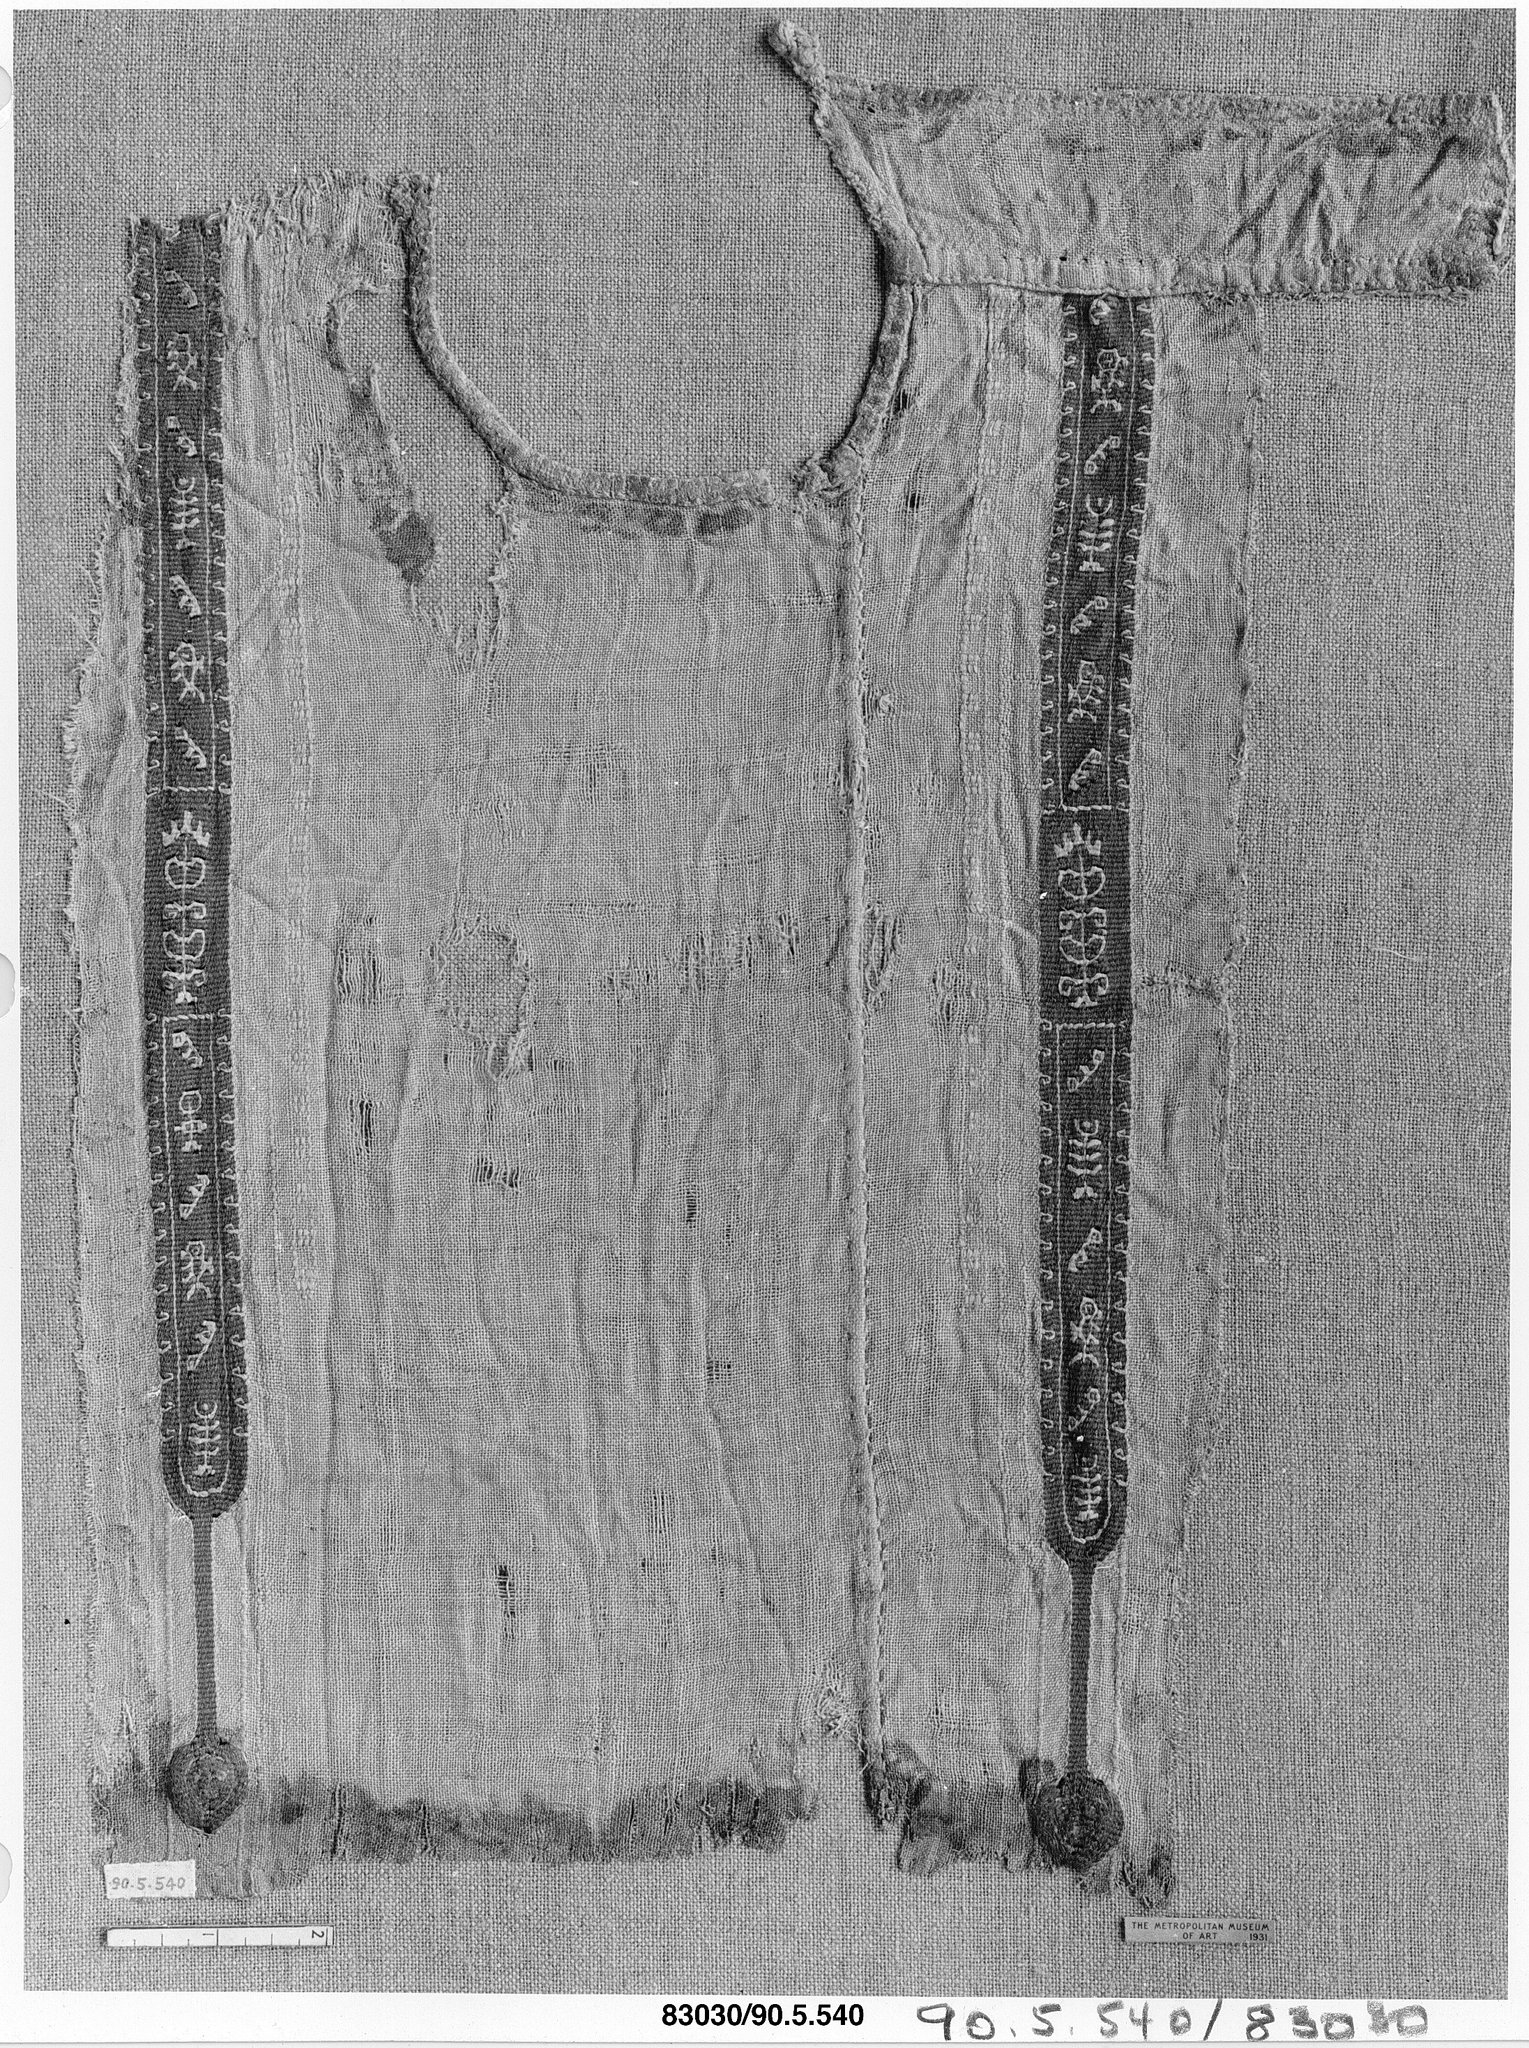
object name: tunic fragment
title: Fragment of a Tunic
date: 301-500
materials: linen, wool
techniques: weave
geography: egypt